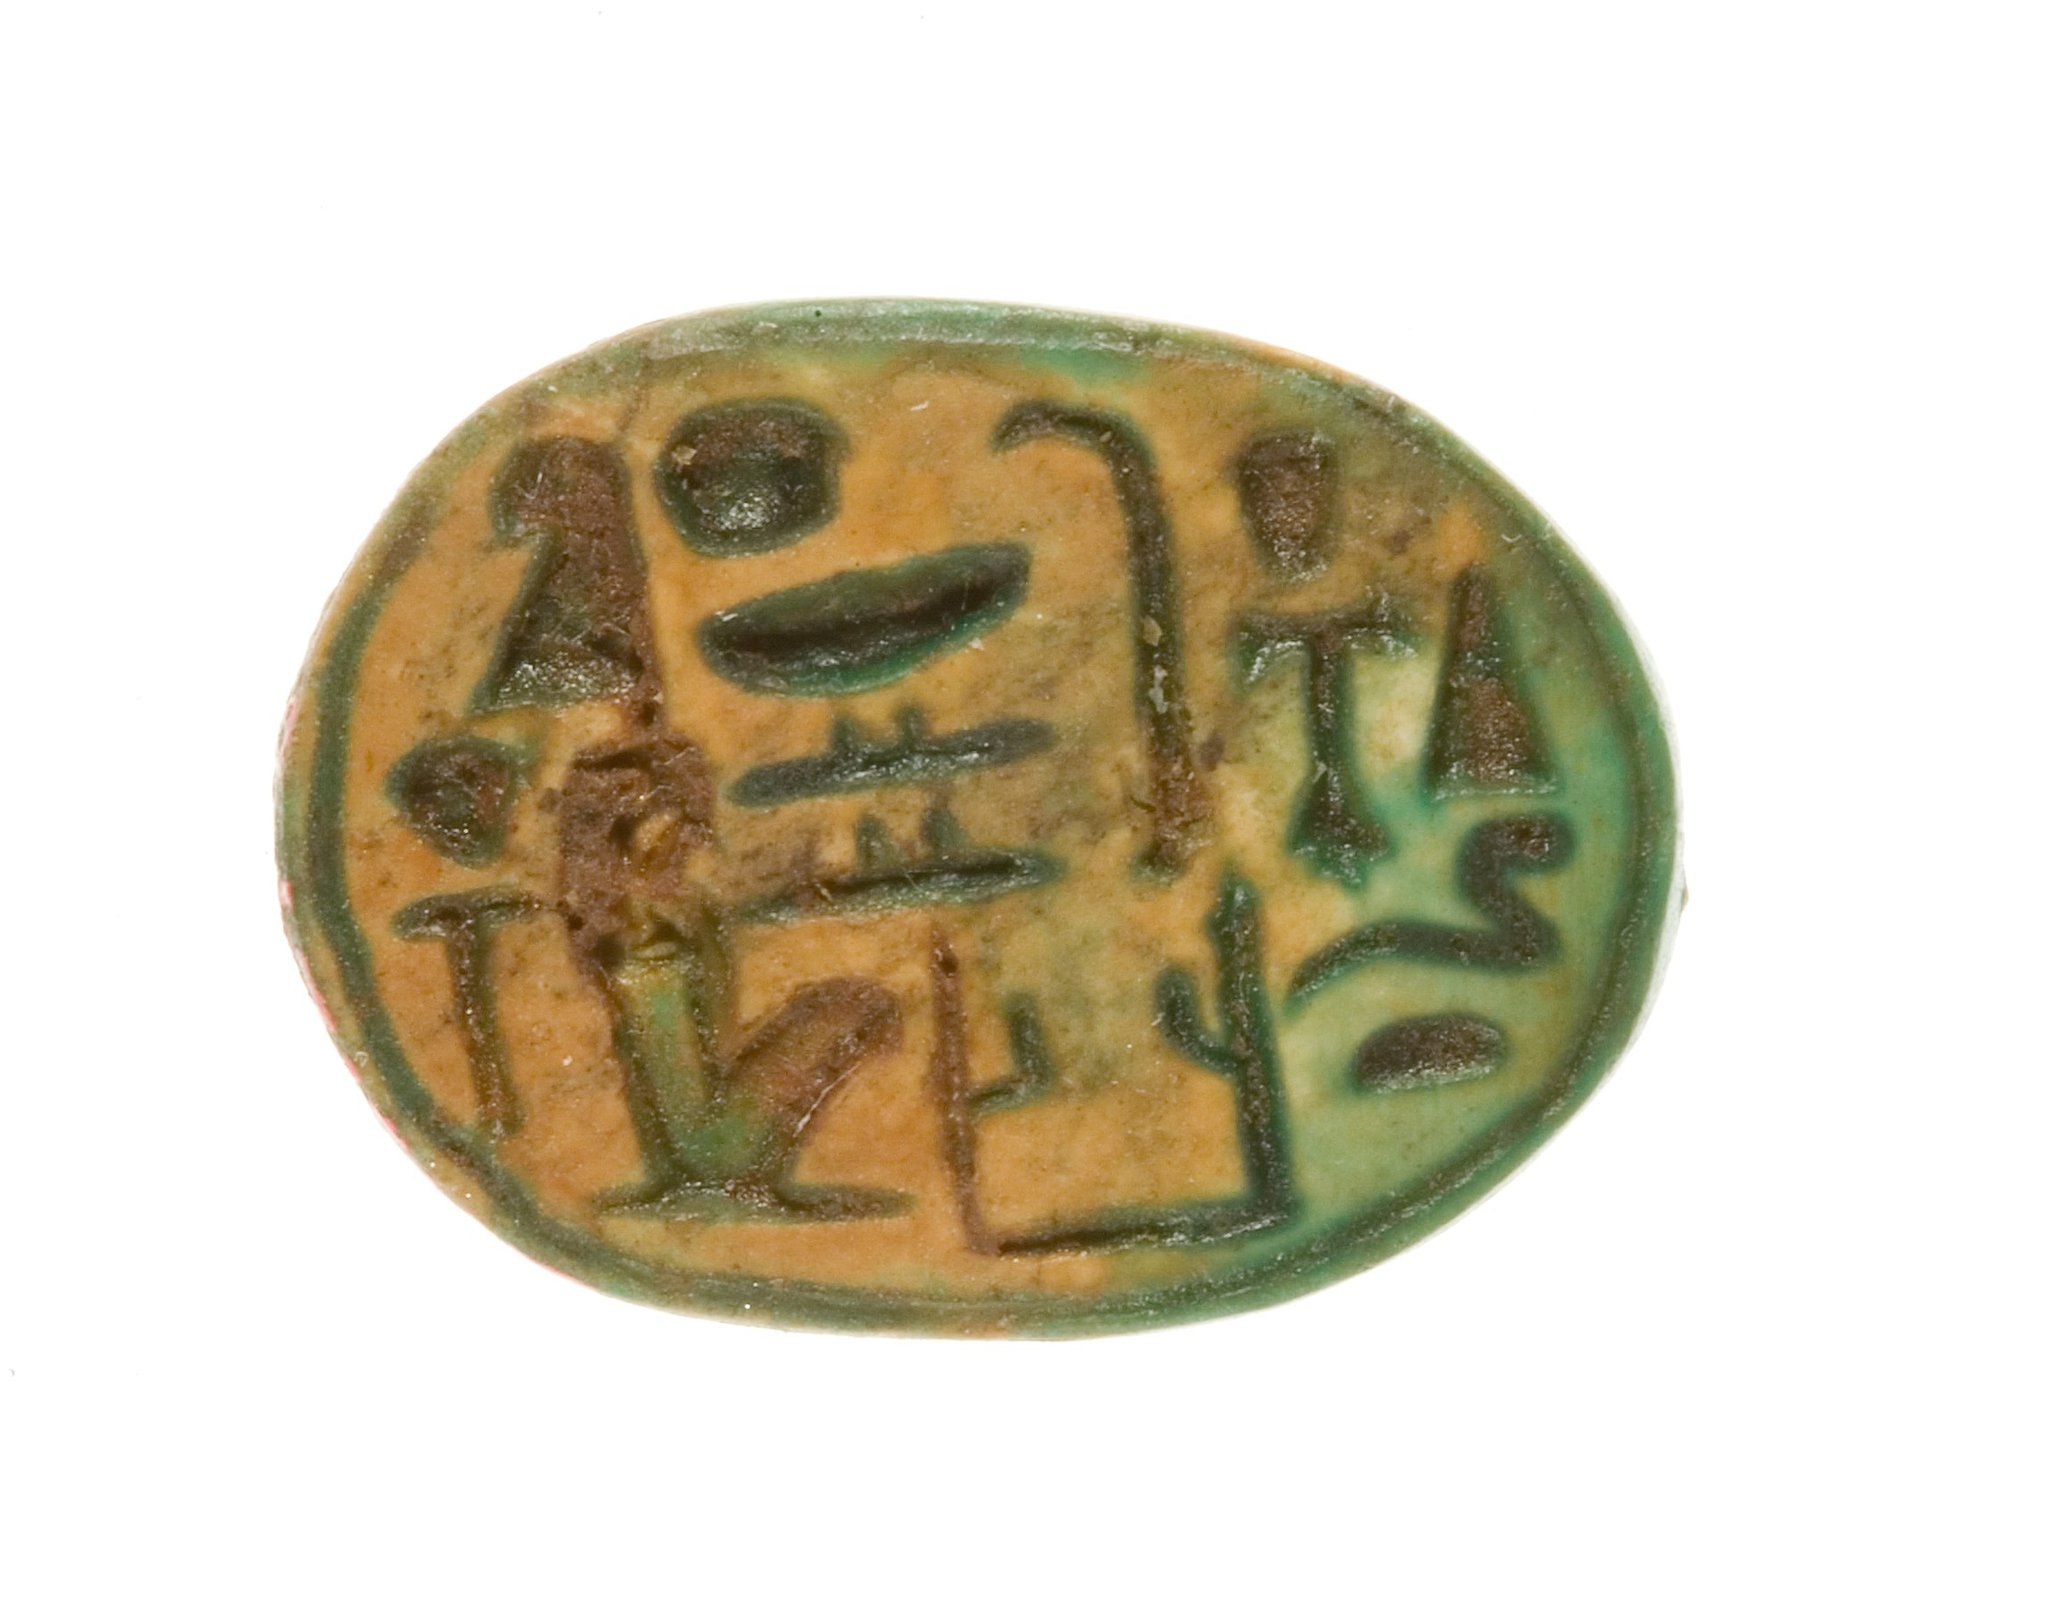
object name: scarab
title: Scarab Inscribed Lord of the Two Lands Maatkare (Hatshepsut), Given Life Forever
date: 1479-1458 BCE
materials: stone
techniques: glazing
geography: egypt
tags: hieroglyphs,scarabs